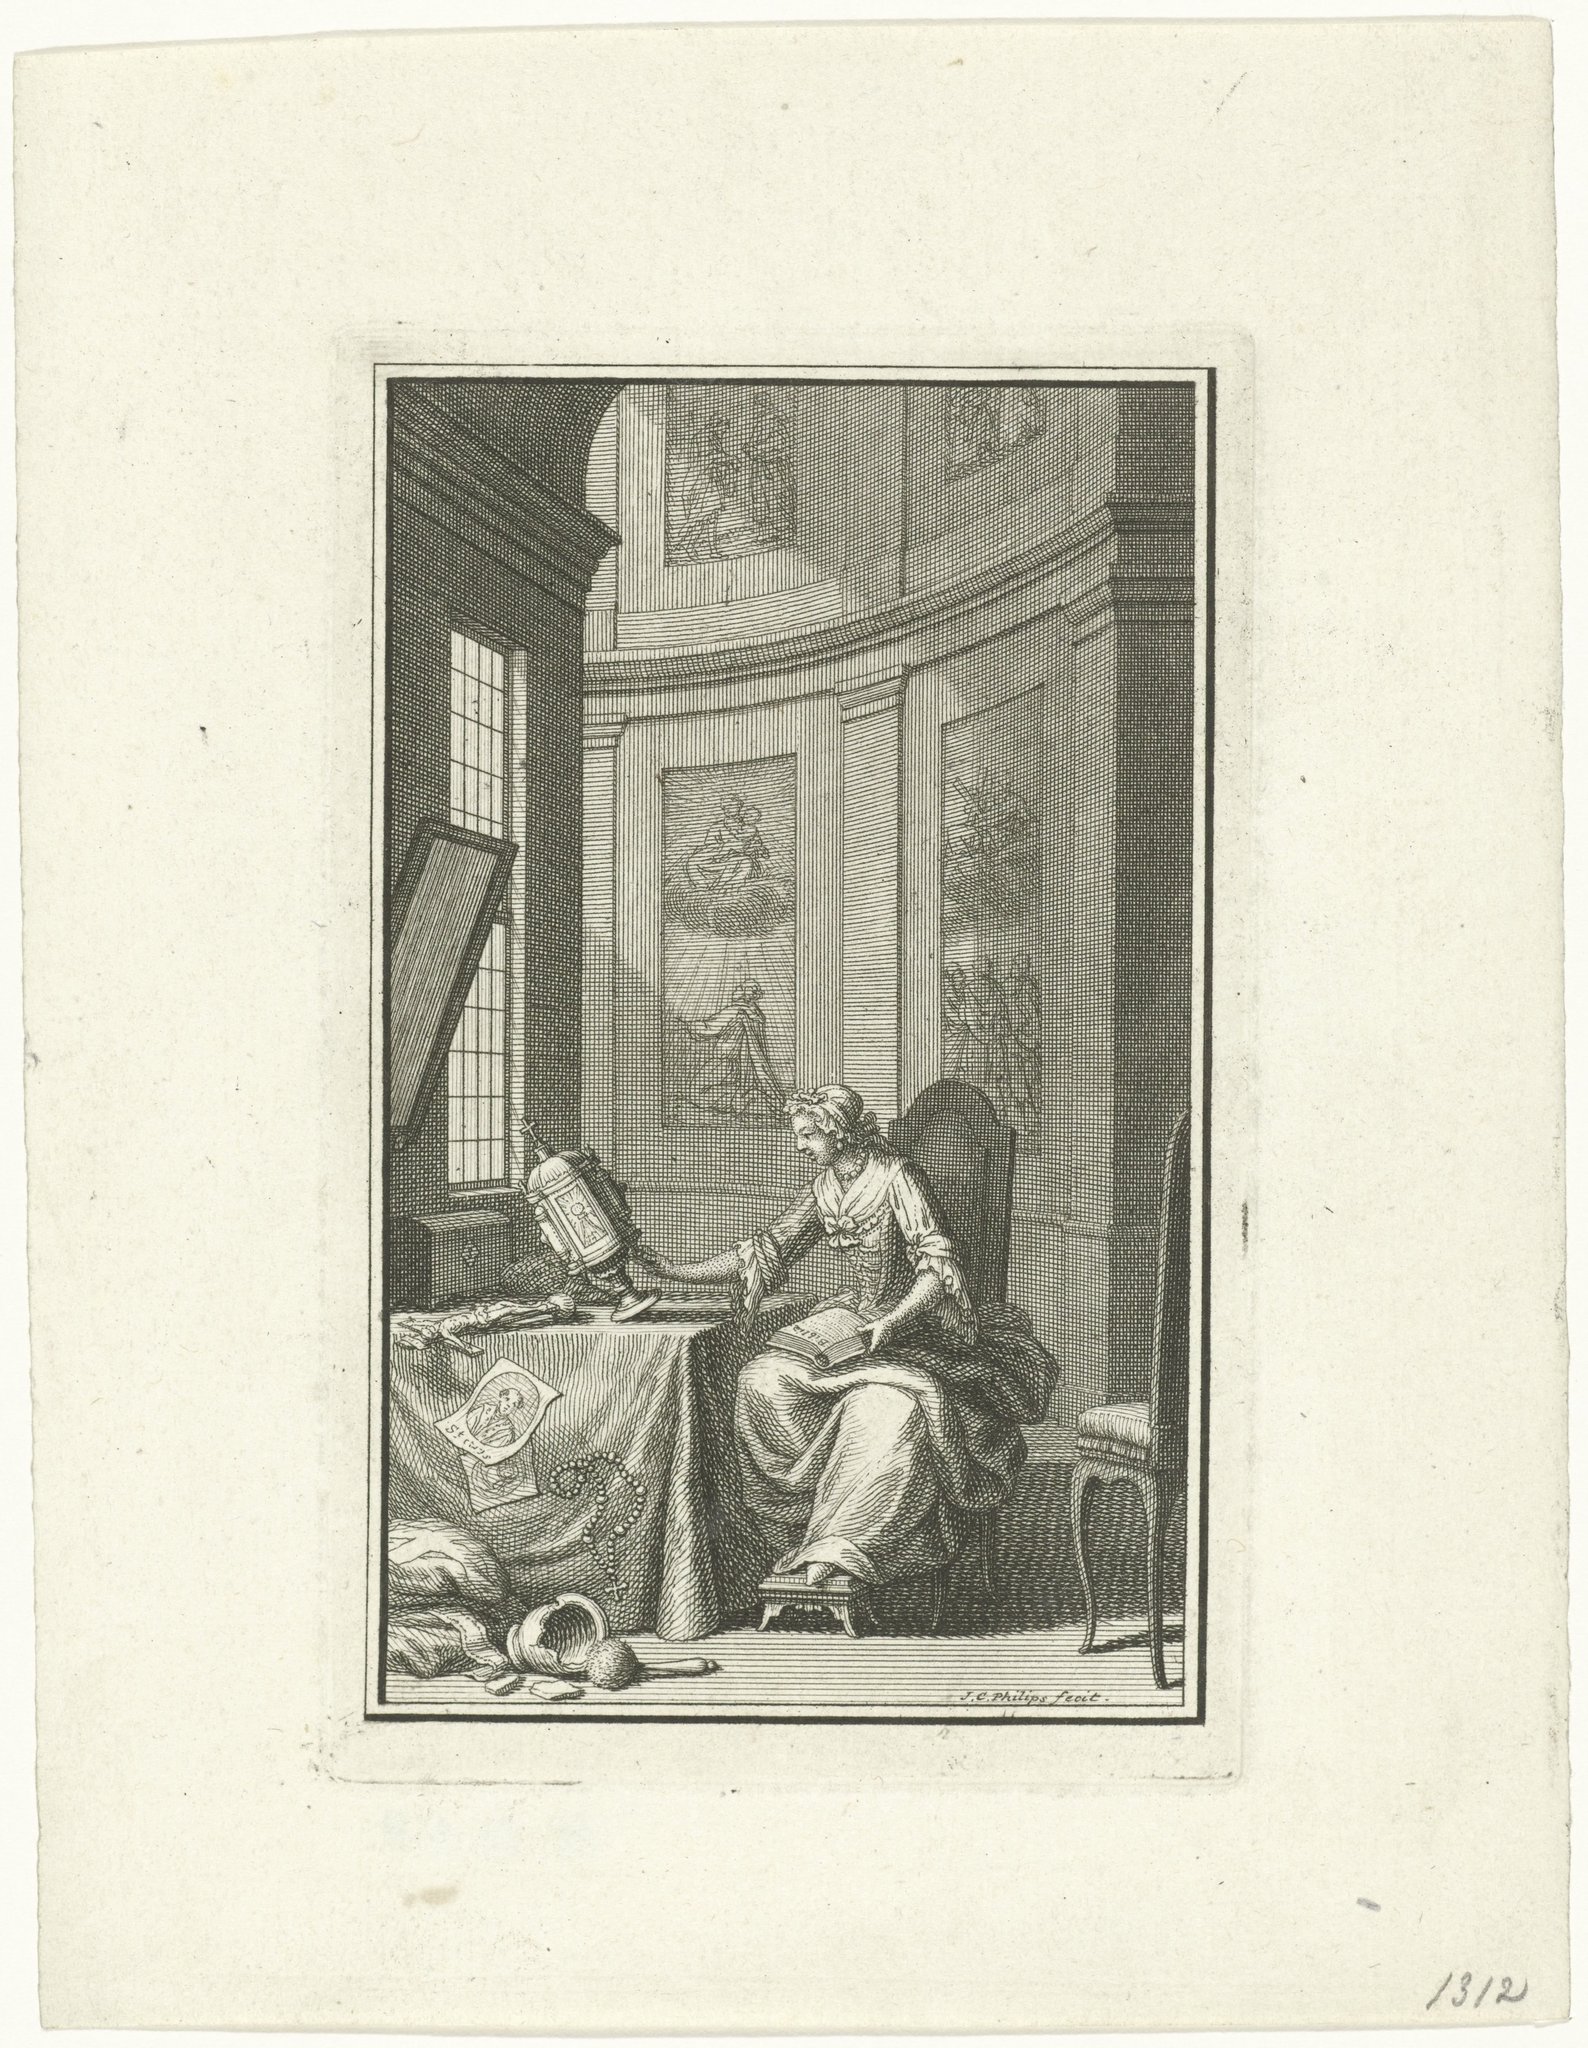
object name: print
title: Interieur met een vrouw die de bijbel leest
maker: jan caspar philips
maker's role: draughtsman, print maker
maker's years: 1700-1775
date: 1736-1775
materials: paper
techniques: engraving, etching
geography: amsterdam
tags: reading the bible or other religious books, ciborium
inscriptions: collector's mark: Lugt 2228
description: Interieur met een vrouw die, zittend aan een tafel, de bijbel leest. Ze bekijkt een rijk gedecoreerde ciborie. Op de achtergrond tegen de wand panelen met christelijke voorstellingen.